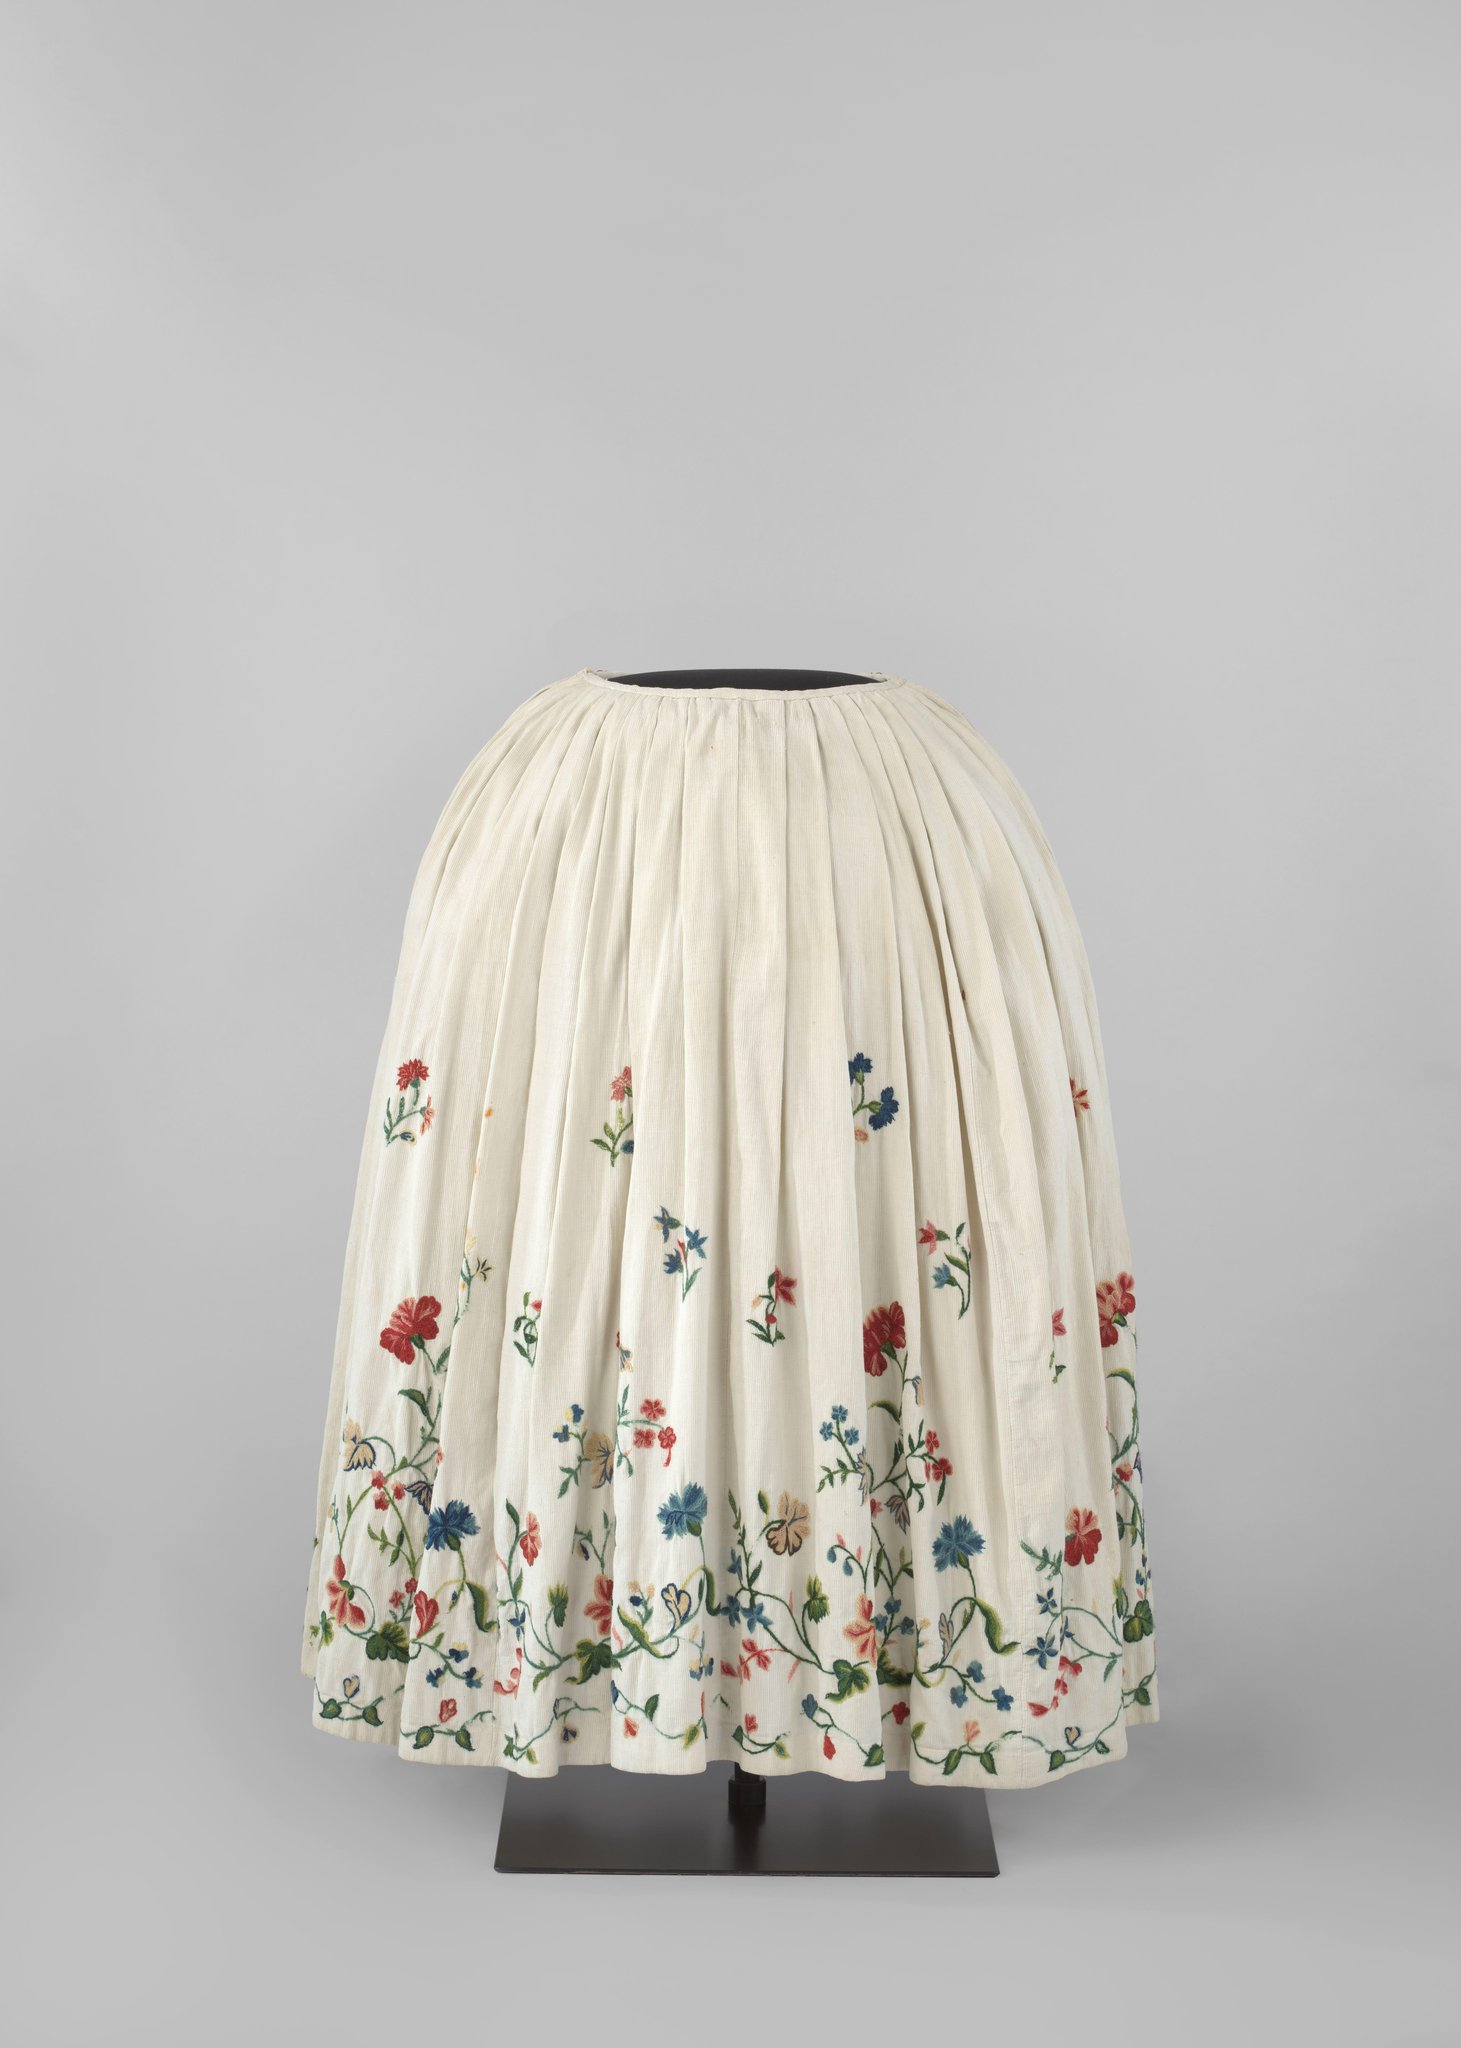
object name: skirt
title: Ongevoerde rok met zijsplitten van witte geribde katoen, meerkleurig in wol getamboereerd (?) met bloem- en bladranken en losse bloem- en bladtakken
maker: Anonymous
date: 1700-1800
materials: cotton, wool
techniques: embroidered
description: Rok van zware geribde witte katoen, waarop geborduurde wollen bloemen en takken.